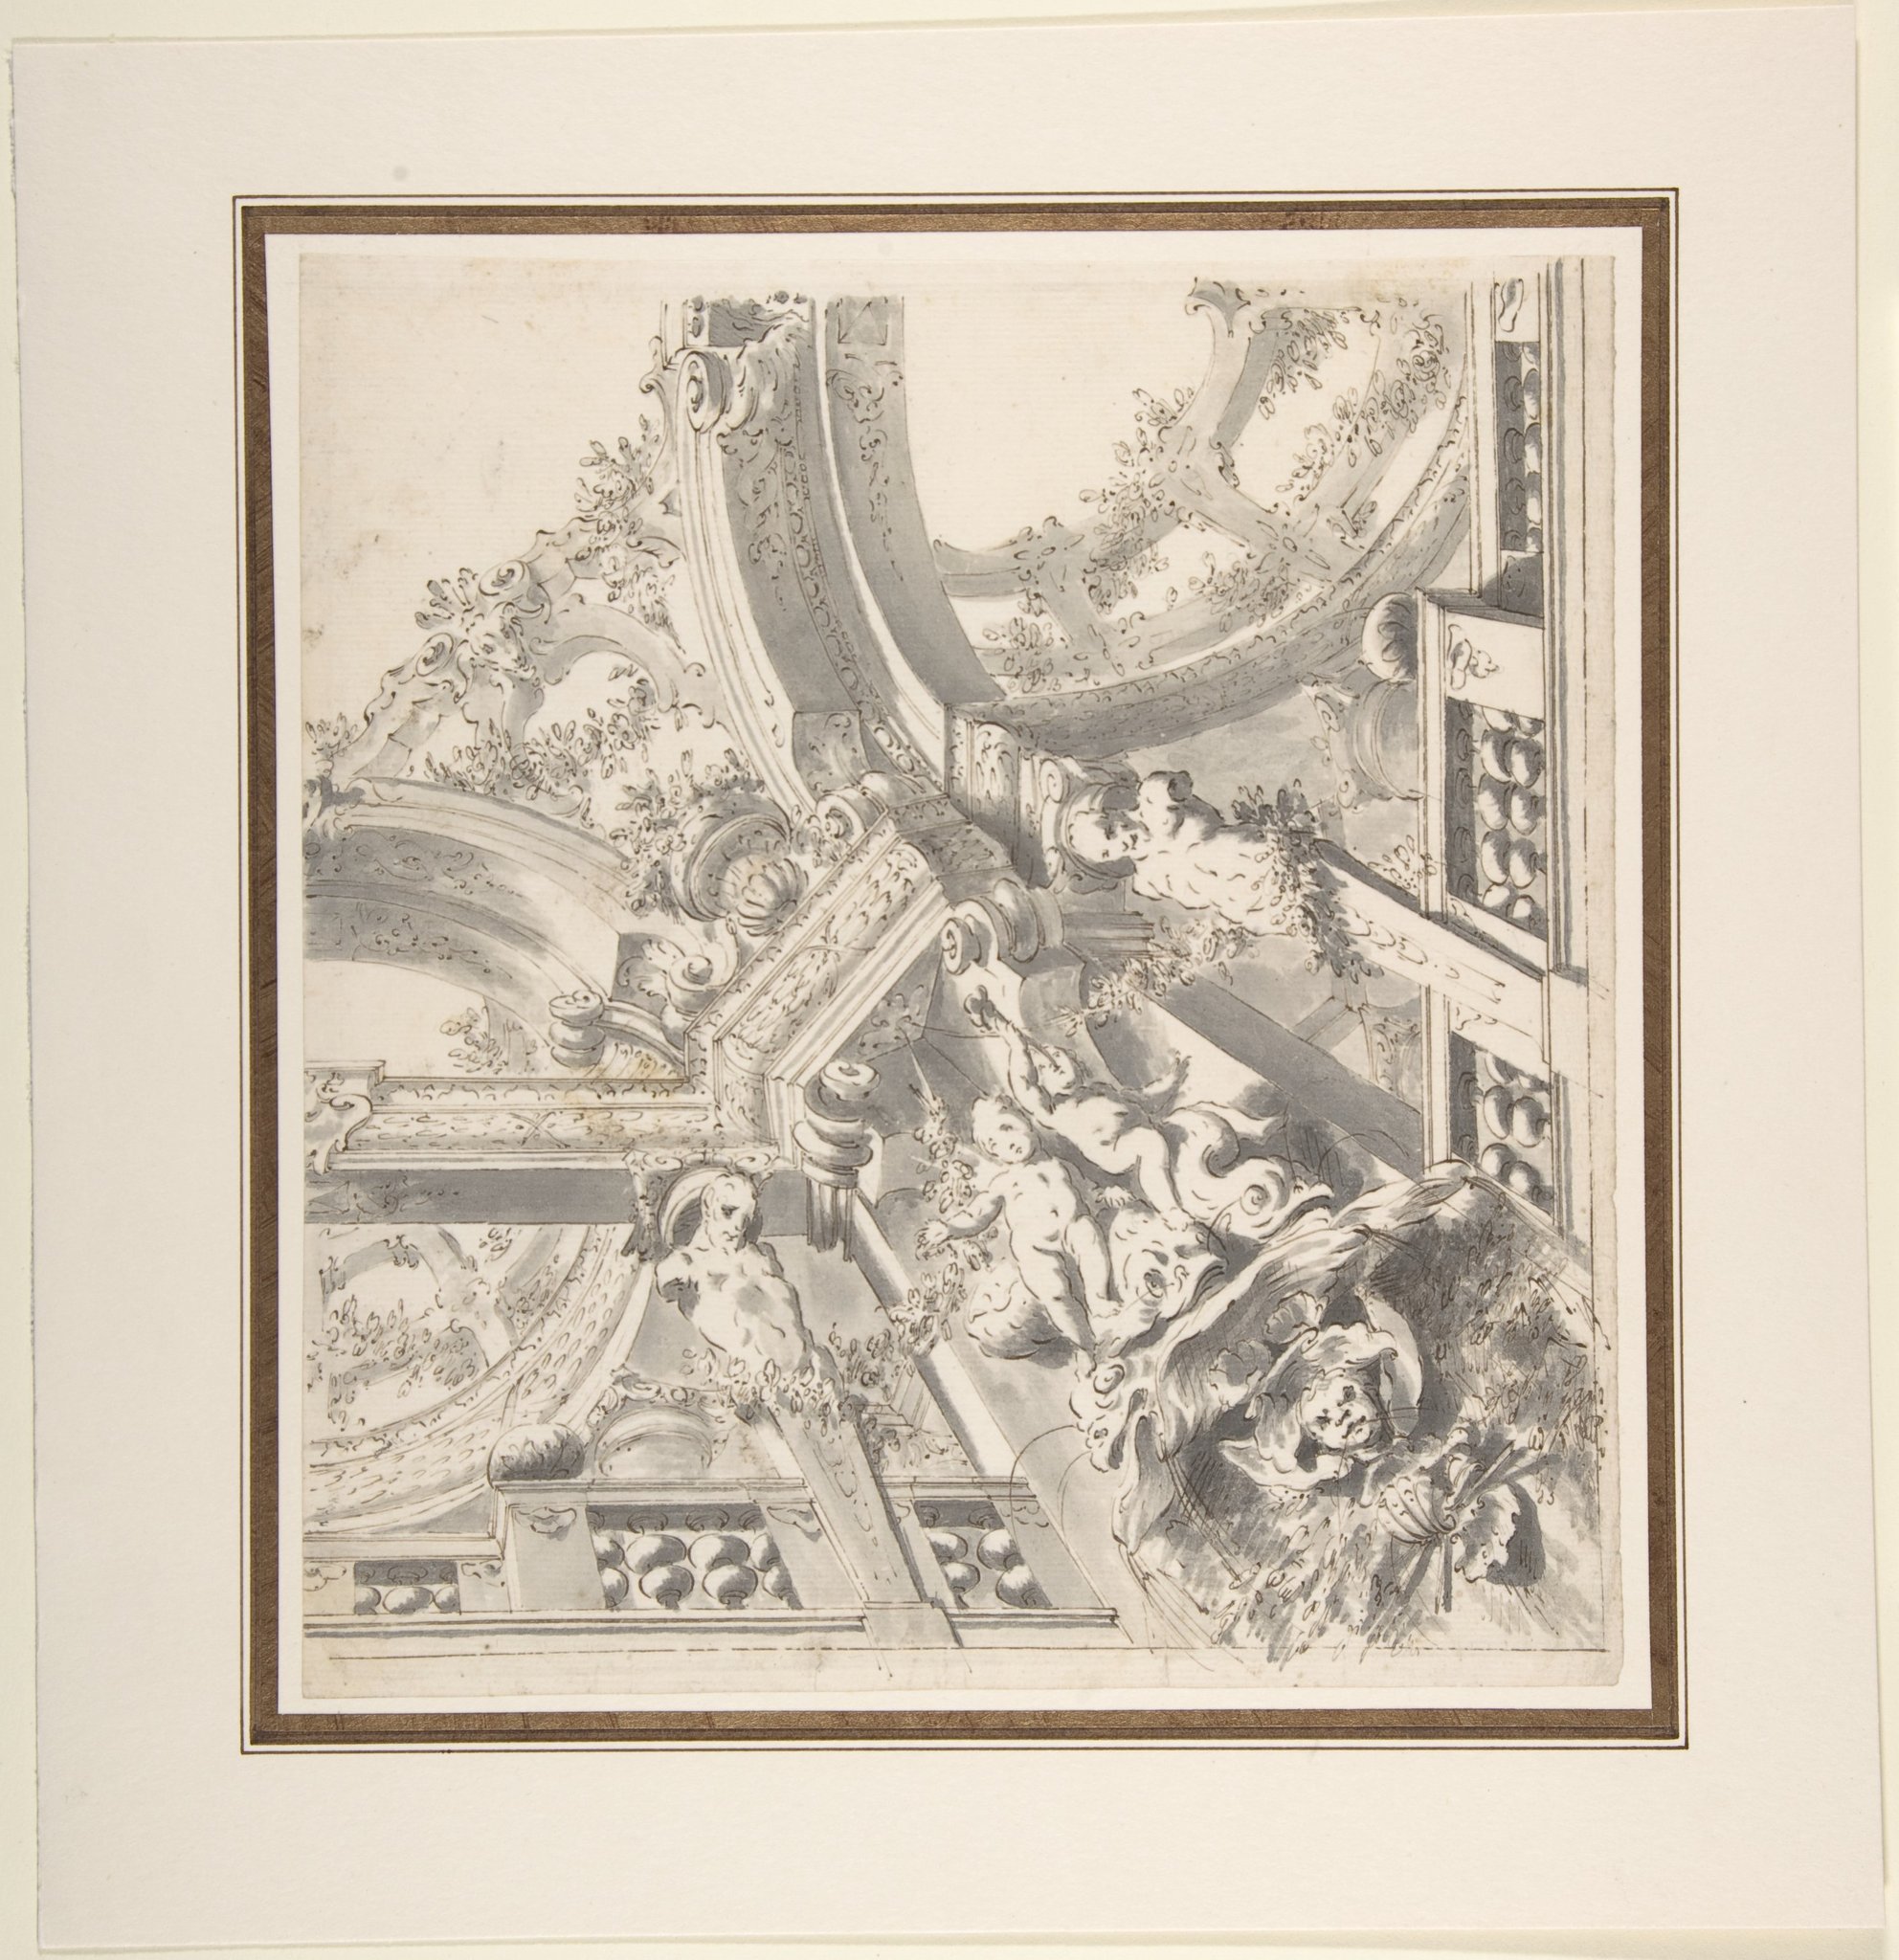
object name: drawing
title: One Quarter Design for a Painted Ceiling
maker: mauro antonio tesi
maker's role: artist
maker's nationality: italian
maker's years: 1730-1766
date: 1730-1766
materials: ink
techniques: brush, pen, wash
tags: architecture,putti